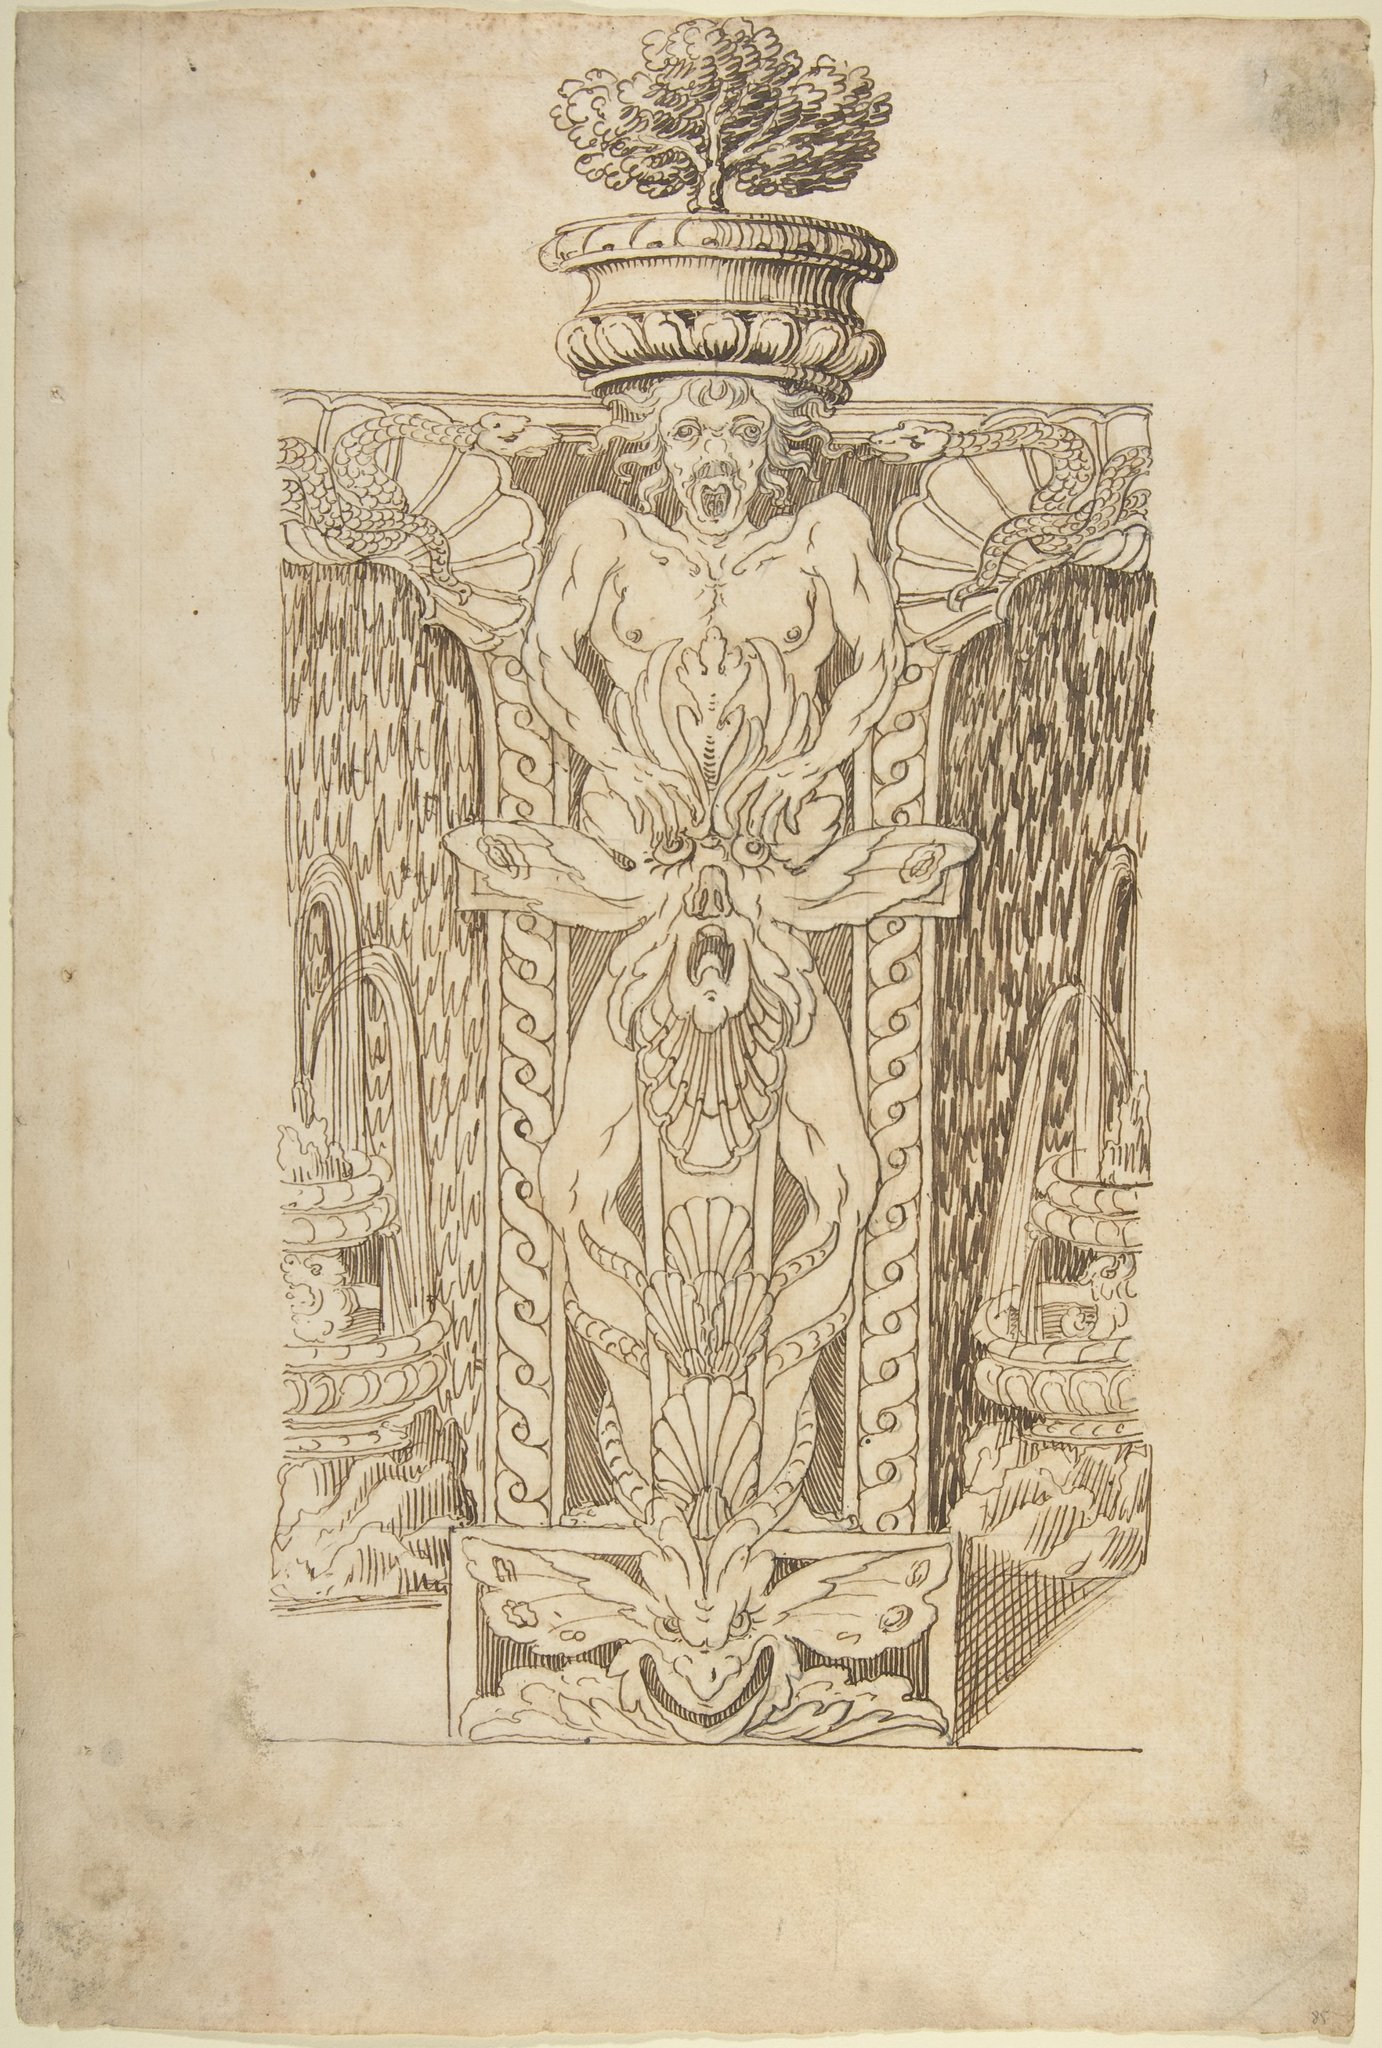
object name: drawing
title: Design for a Wall Fountain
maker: anonymous, italian, lombard, 16th century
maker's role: artist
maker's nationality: italian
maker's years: 1500-1600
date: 1550-1620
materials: ink, drawing material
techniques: brush, pen, wash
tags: fountains,mythical creatures